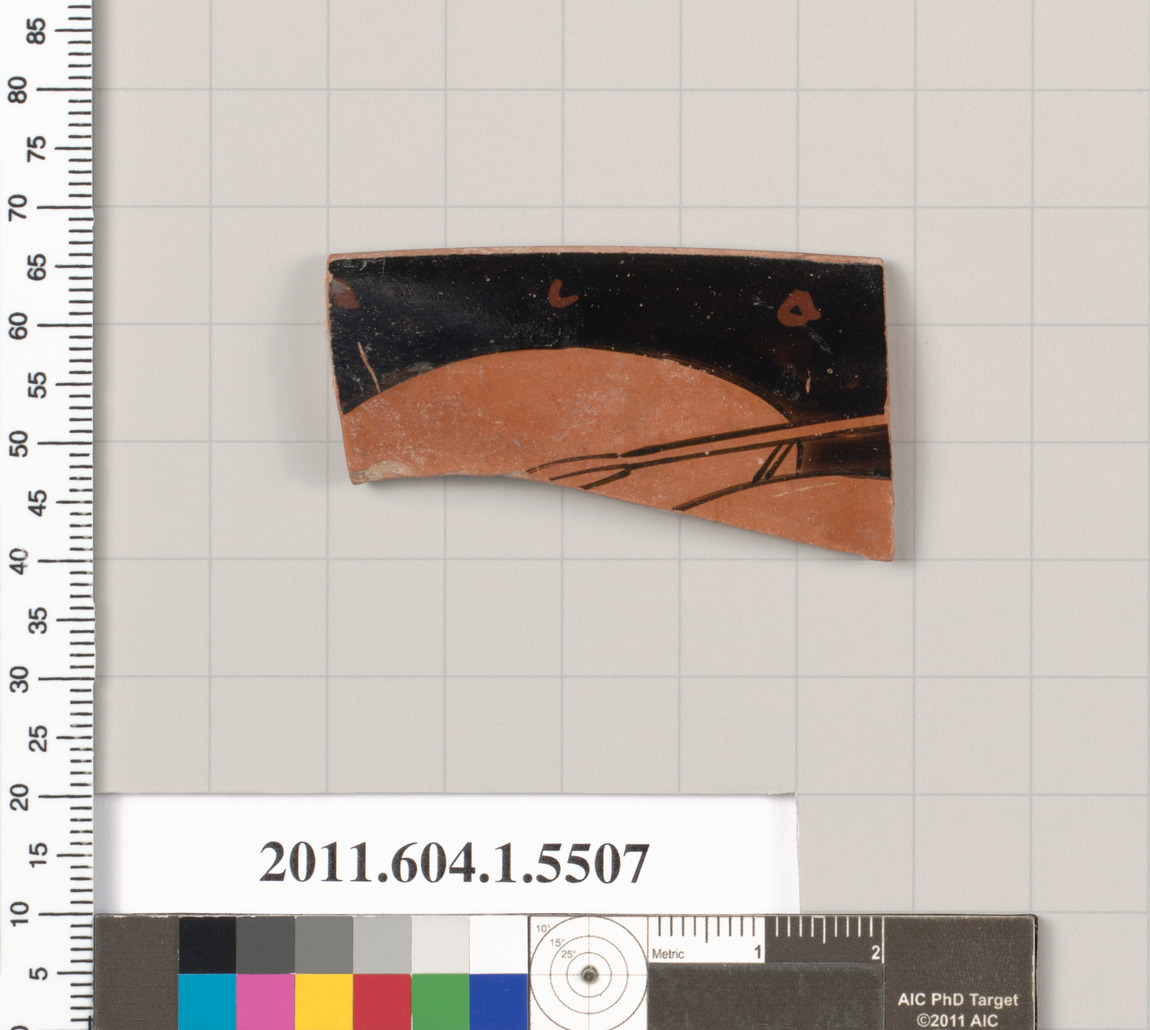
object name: kylix fragment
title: Terracotta rim fragment of a kylix (drinking cup)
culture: greek, attic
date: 510-500 BCE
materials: terracotta